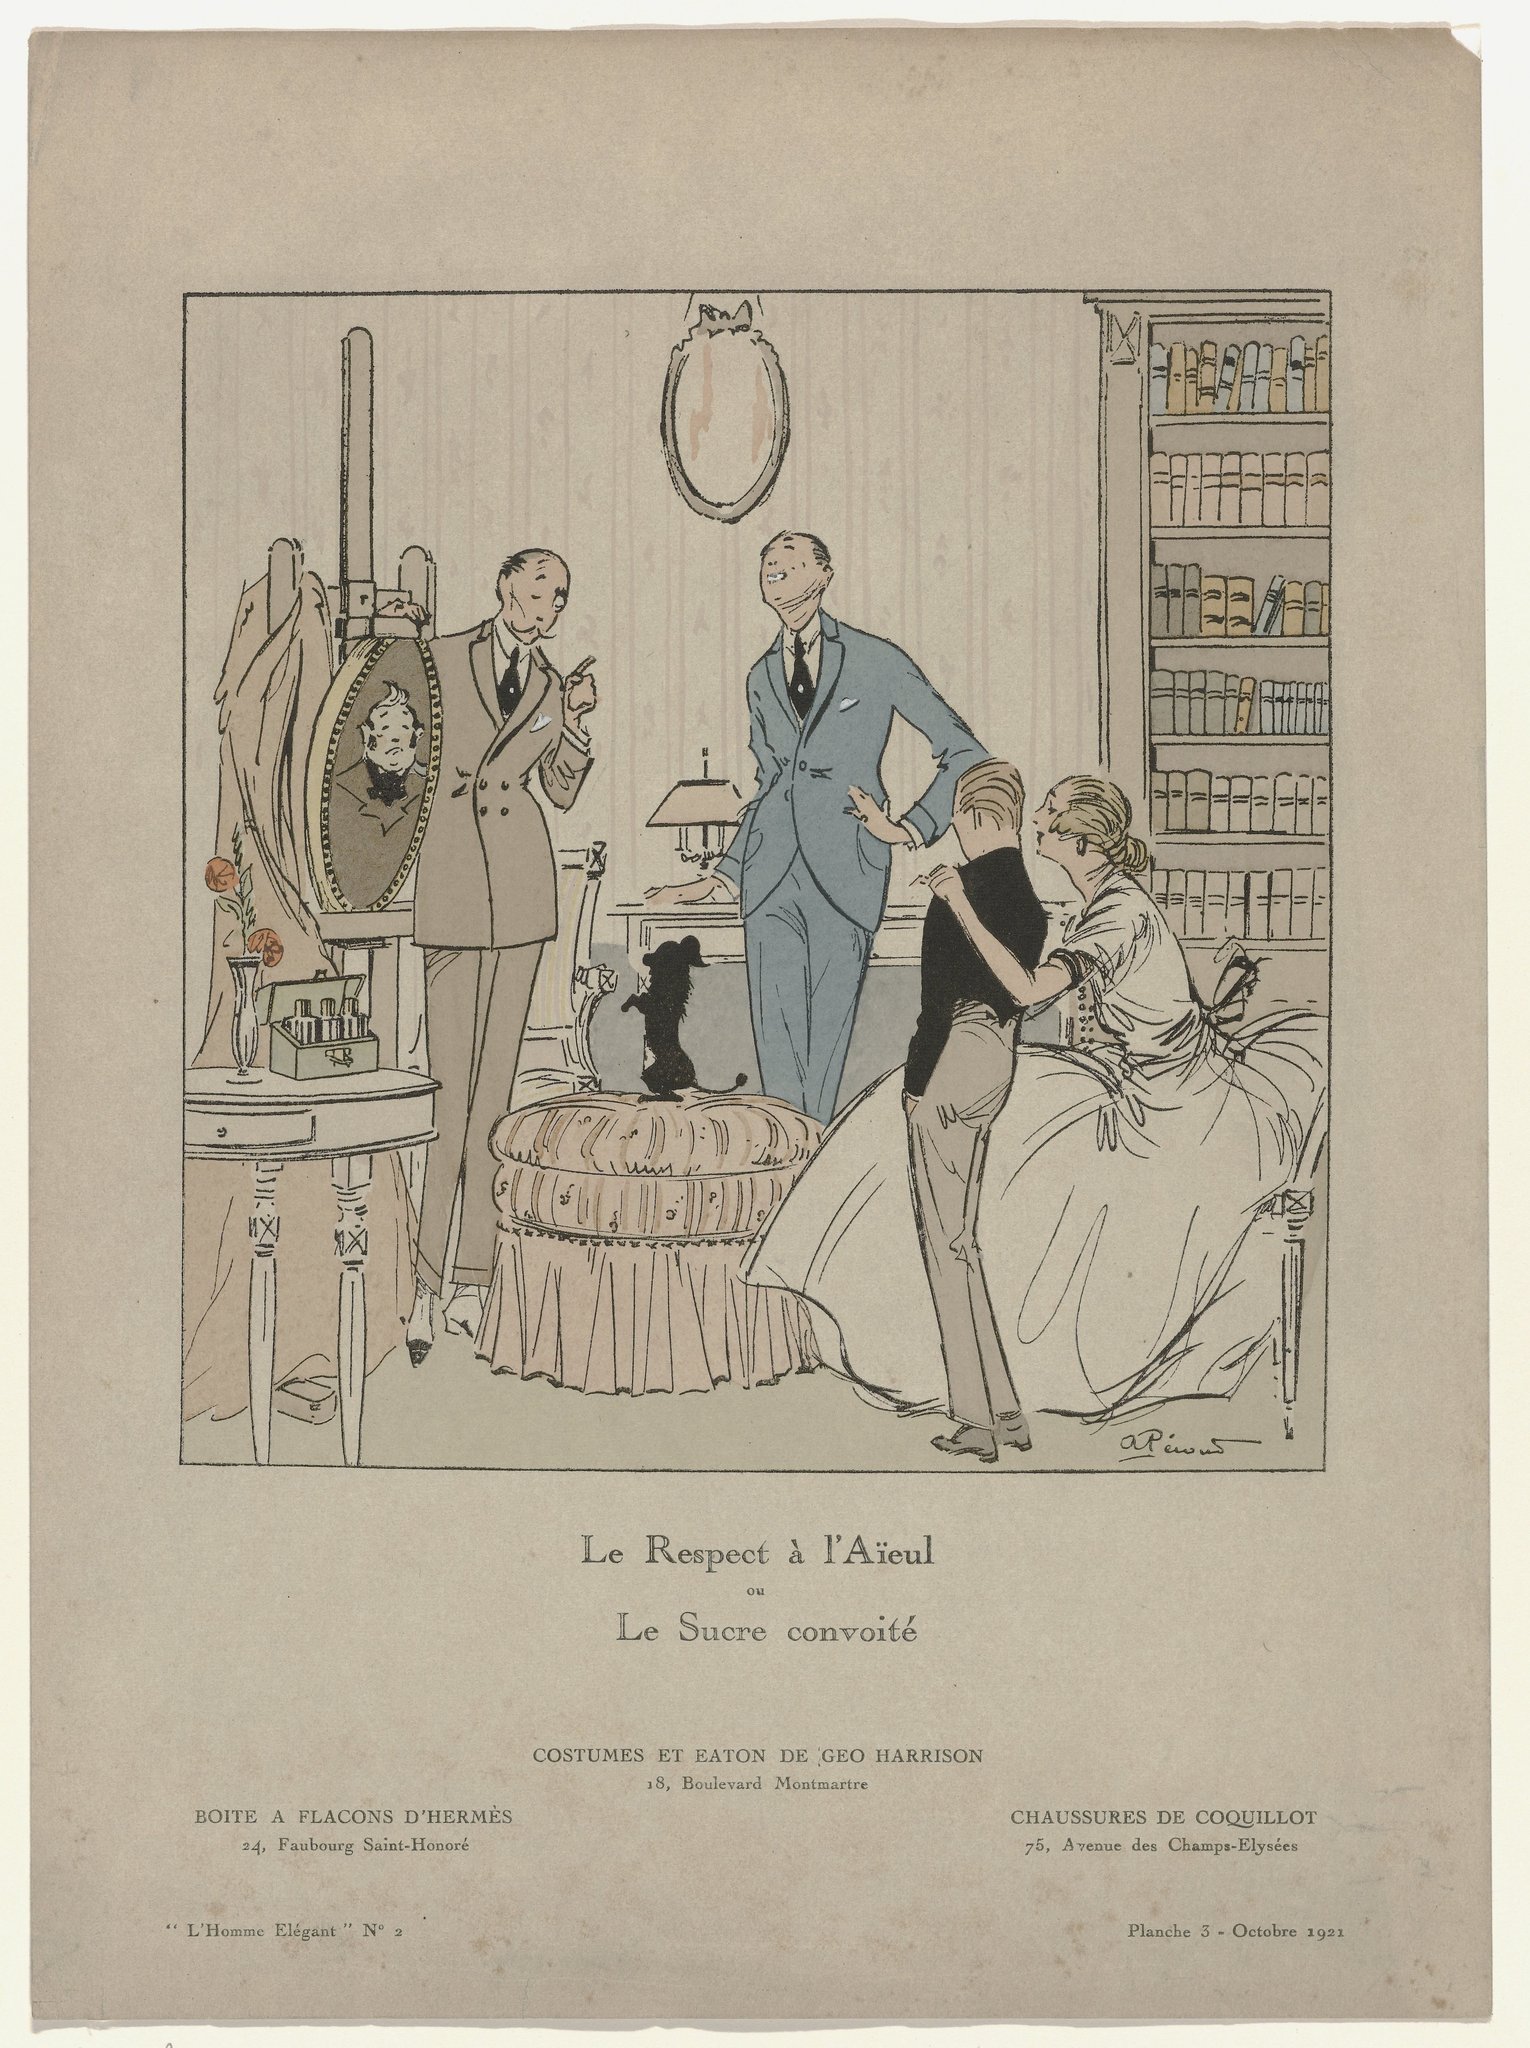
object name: fashion print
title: L'Homme Elégant No.2, Octobre 1921, Pl. 3 : Le Respect à l'Aieul (...).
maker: Anonymous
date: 1921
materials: paper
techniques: hand coloring, lithograph, pochoir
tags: perfume bottle, neck-gear ~ clothing (tie) (+ men's clothes), clothes, costume (+ boys' clothes), coat (+ men's clothes), anonymous historical person portrayed alone, fashion plates, dress, gown (+ women's clothes), communal rooms, easel, dog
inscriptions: caption: ‘Le Respect à l'Aïeul ou Le Sucre convoité. ? COSTUMES ET EATON DE GEO HARRISON 18, Boulevard Montmartre. / BOITE A FLACONS D'HERMÈS 24, Faubourg Saint-Honoré. / CHAUSSURES DE COQUILLOT 75, Avenue des Champs-Elysées.’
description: Twee mannen staan bij een portret op een schildersezel. Kostuums en 'eaton' van Geo Harrison. Op een bijzettafel een doos met flacons van Hermès. Schoenen van Coquillot. Een jongen en zijn moeder luisteren naar wat de man te zeggen heeft. Op de poef zit een hondje op de achterpoten. Volgens het onderschrift gaat het hier over respect voor de voorouders of 'Le sucre convoité'. Prent uit het modetijdschrift L'Homme Elégant (1920-1929).